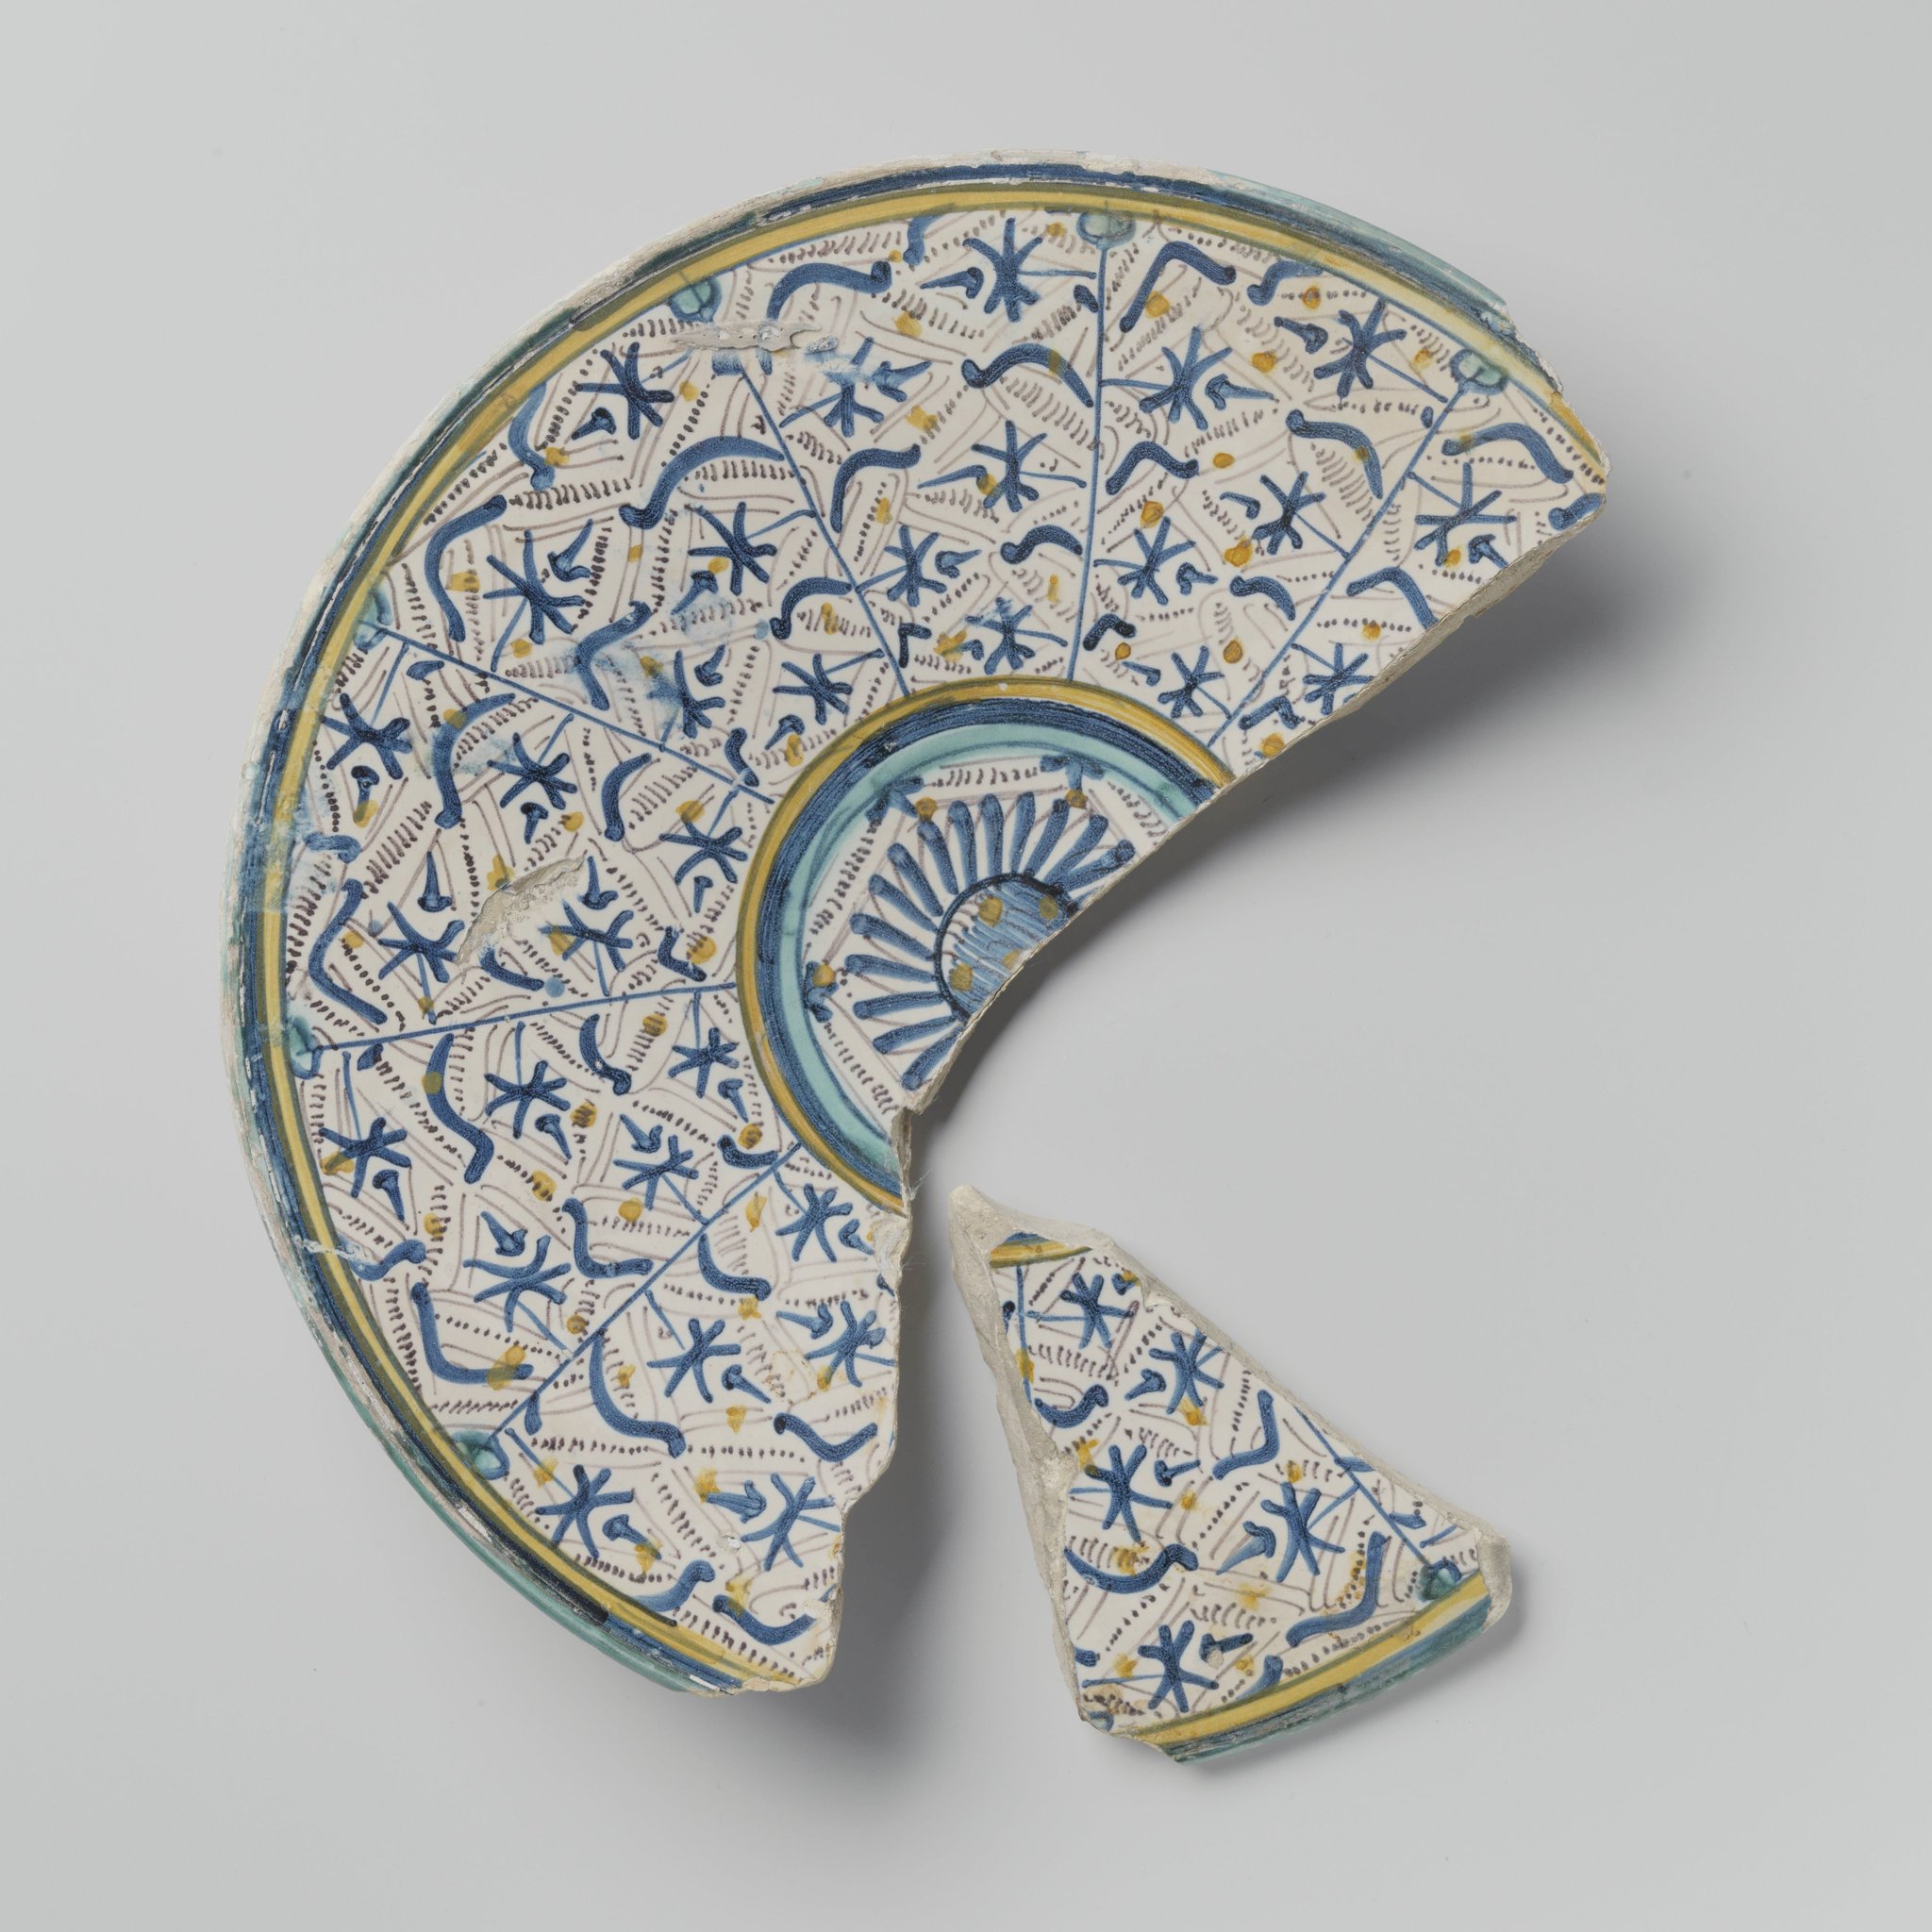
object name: plate dish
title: Bord, in twee fragmenten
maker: Anonymous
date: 1470-1500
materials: earthenware, glaze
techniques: maiolica, painted, polychromy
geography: tuscany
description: Fragment (twee delen) van een bord van veelkleurig beschilderd majolica. De rand is beschilderd met stervormige ornamenten en elkaar kruisende, gestreepte banden. Zie een kan met gelijke beschildering met invnr. BK-NM-11899.